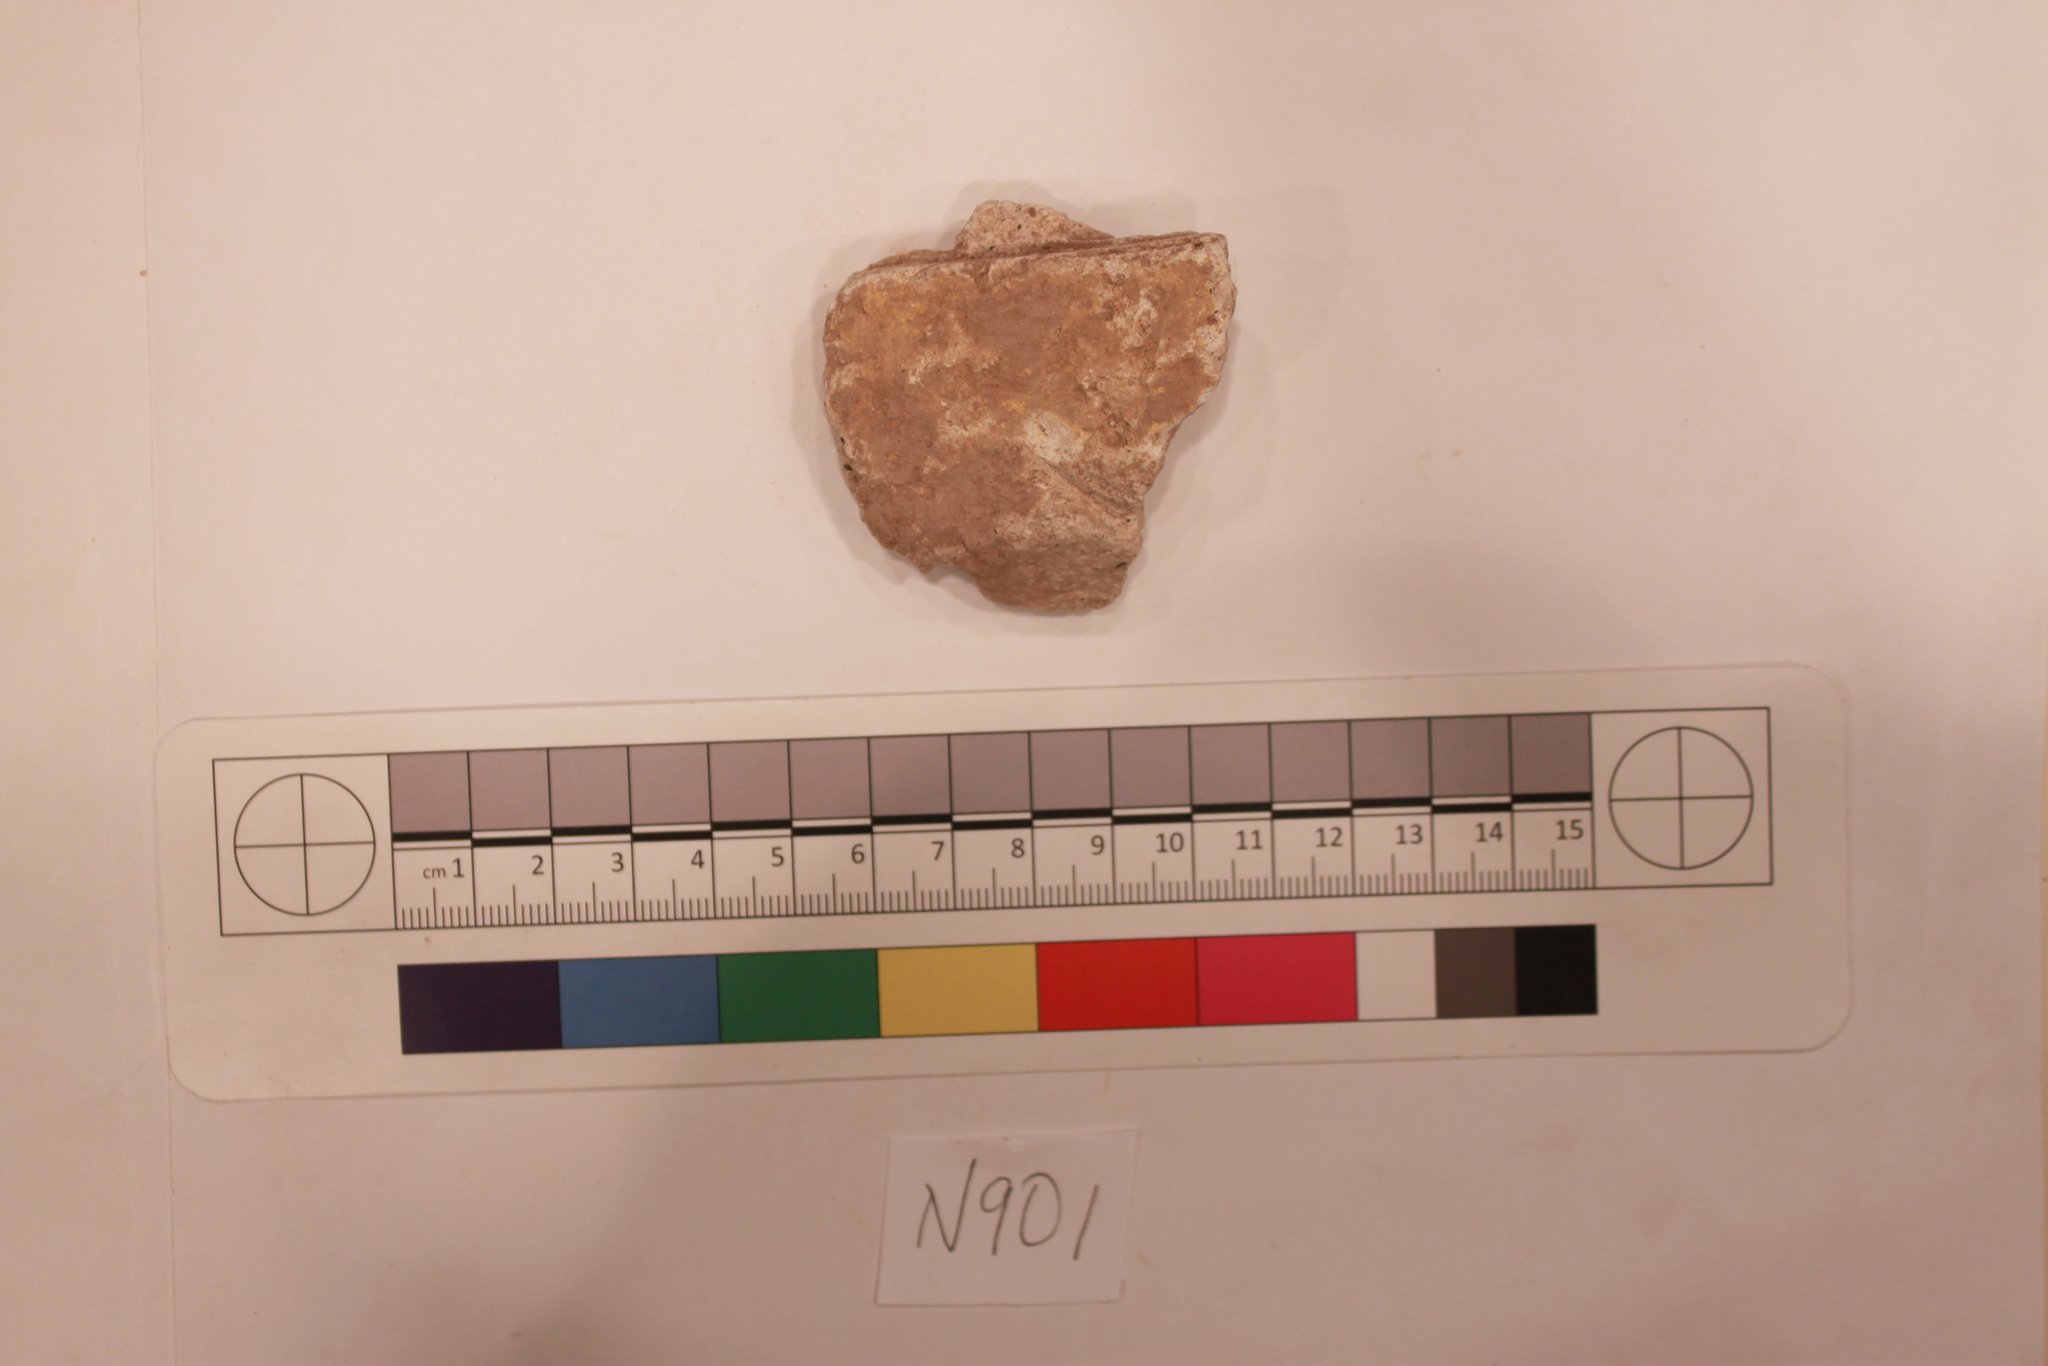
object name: fragment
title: Stucco Fragment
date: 701-1200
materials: plaster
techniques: carving, painting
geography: iran